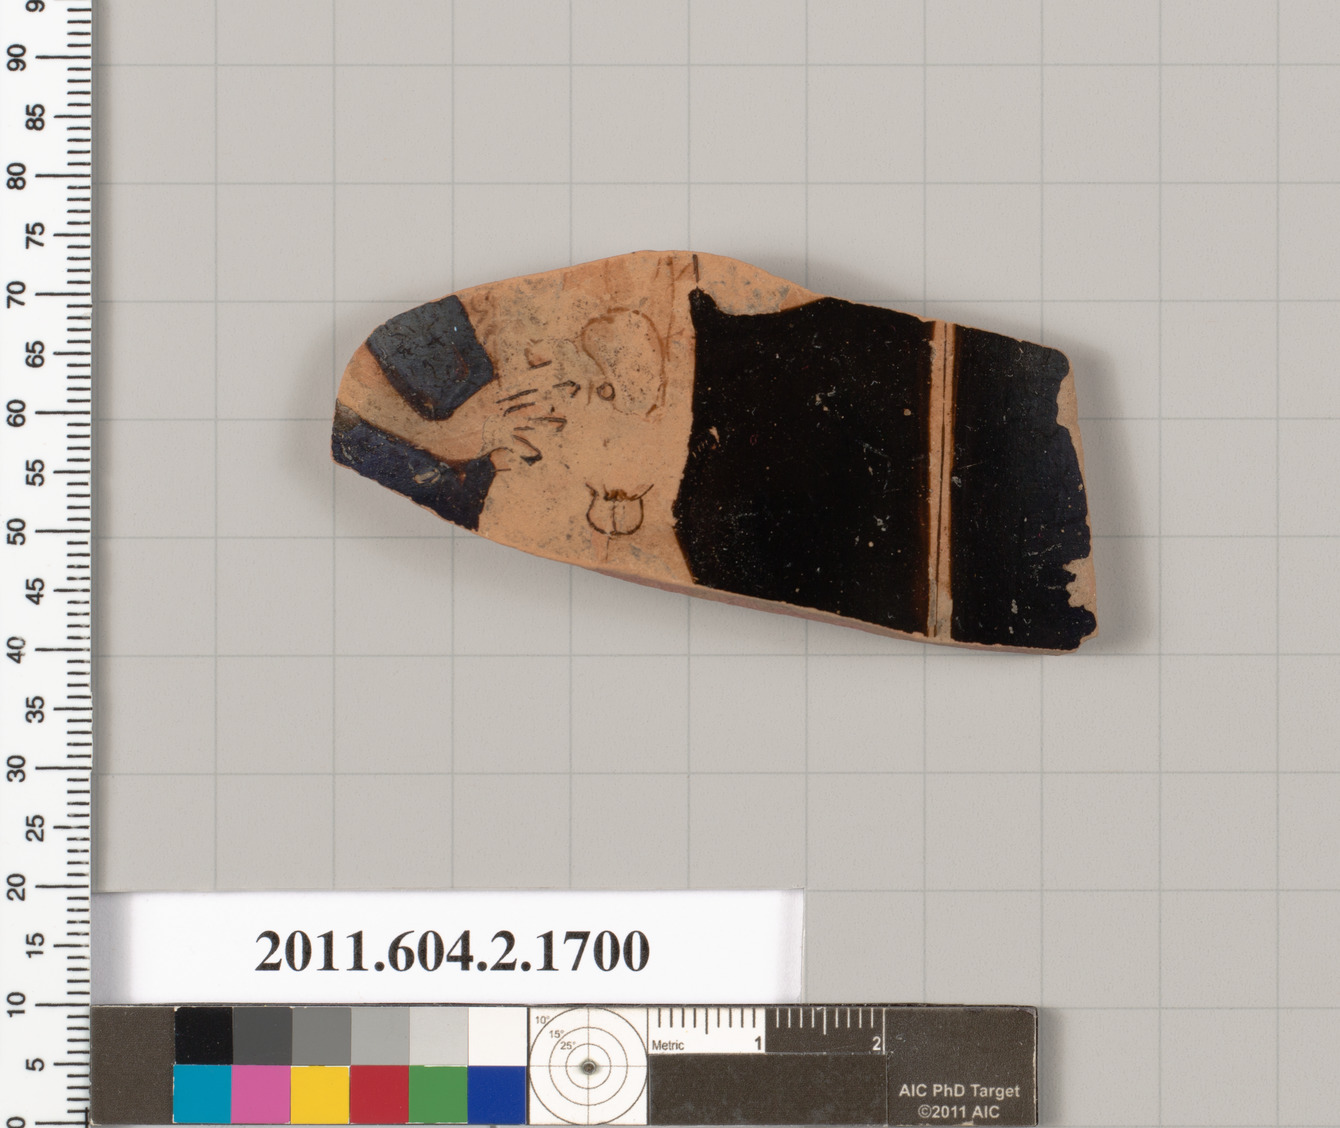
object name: skyphos fragment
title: Terracotta fragment of a skyphos (deep drinking cup)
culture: greek, attic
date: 450-426 BCE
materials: terracotta